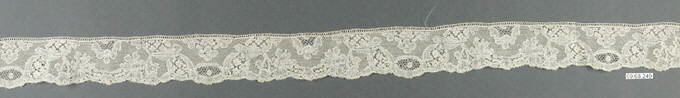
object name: strip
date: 1701-1800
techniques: lace